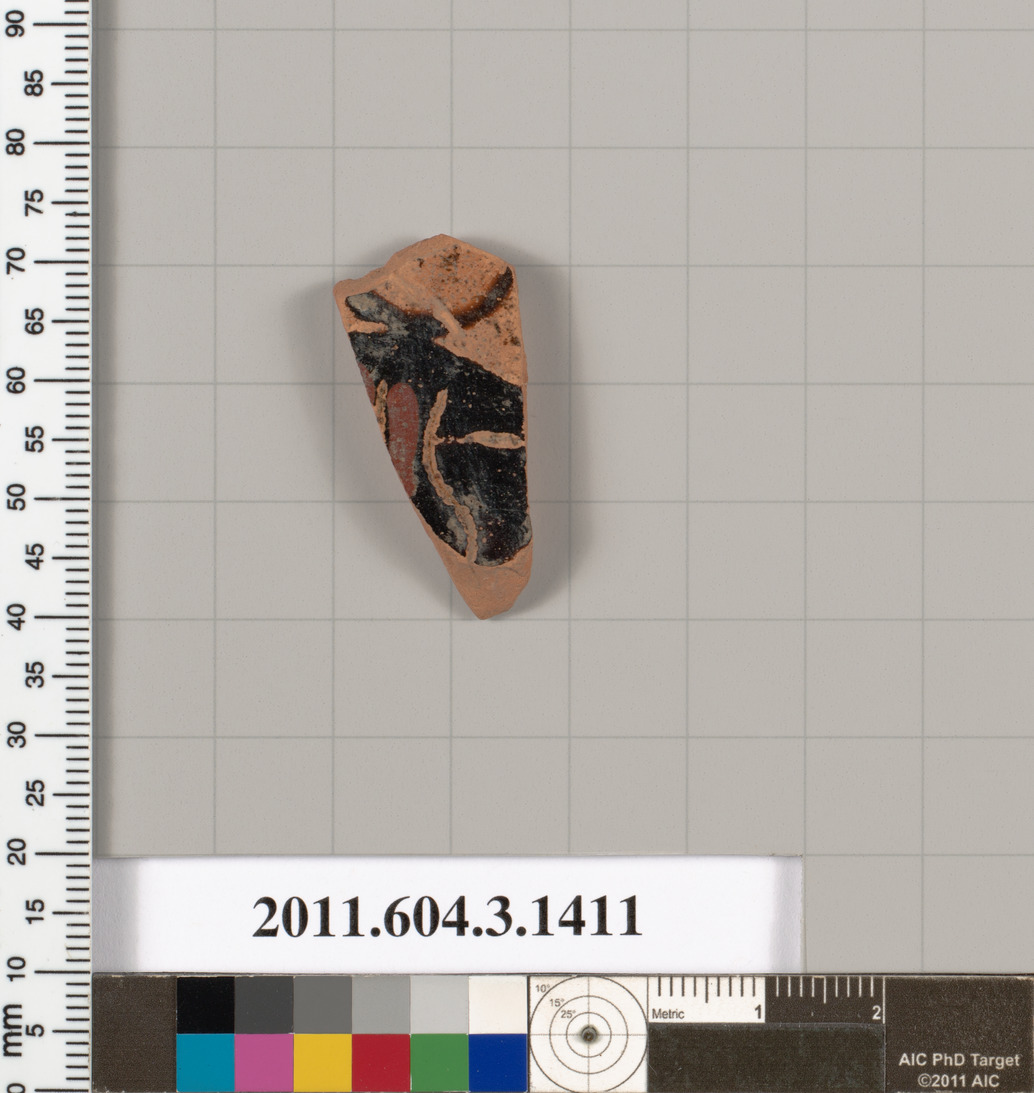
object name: skyphos fragment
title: Terracotta fragment of a skyphos (deep drinking cup)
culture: greek, attic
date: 534-468 BCE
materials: terracotta